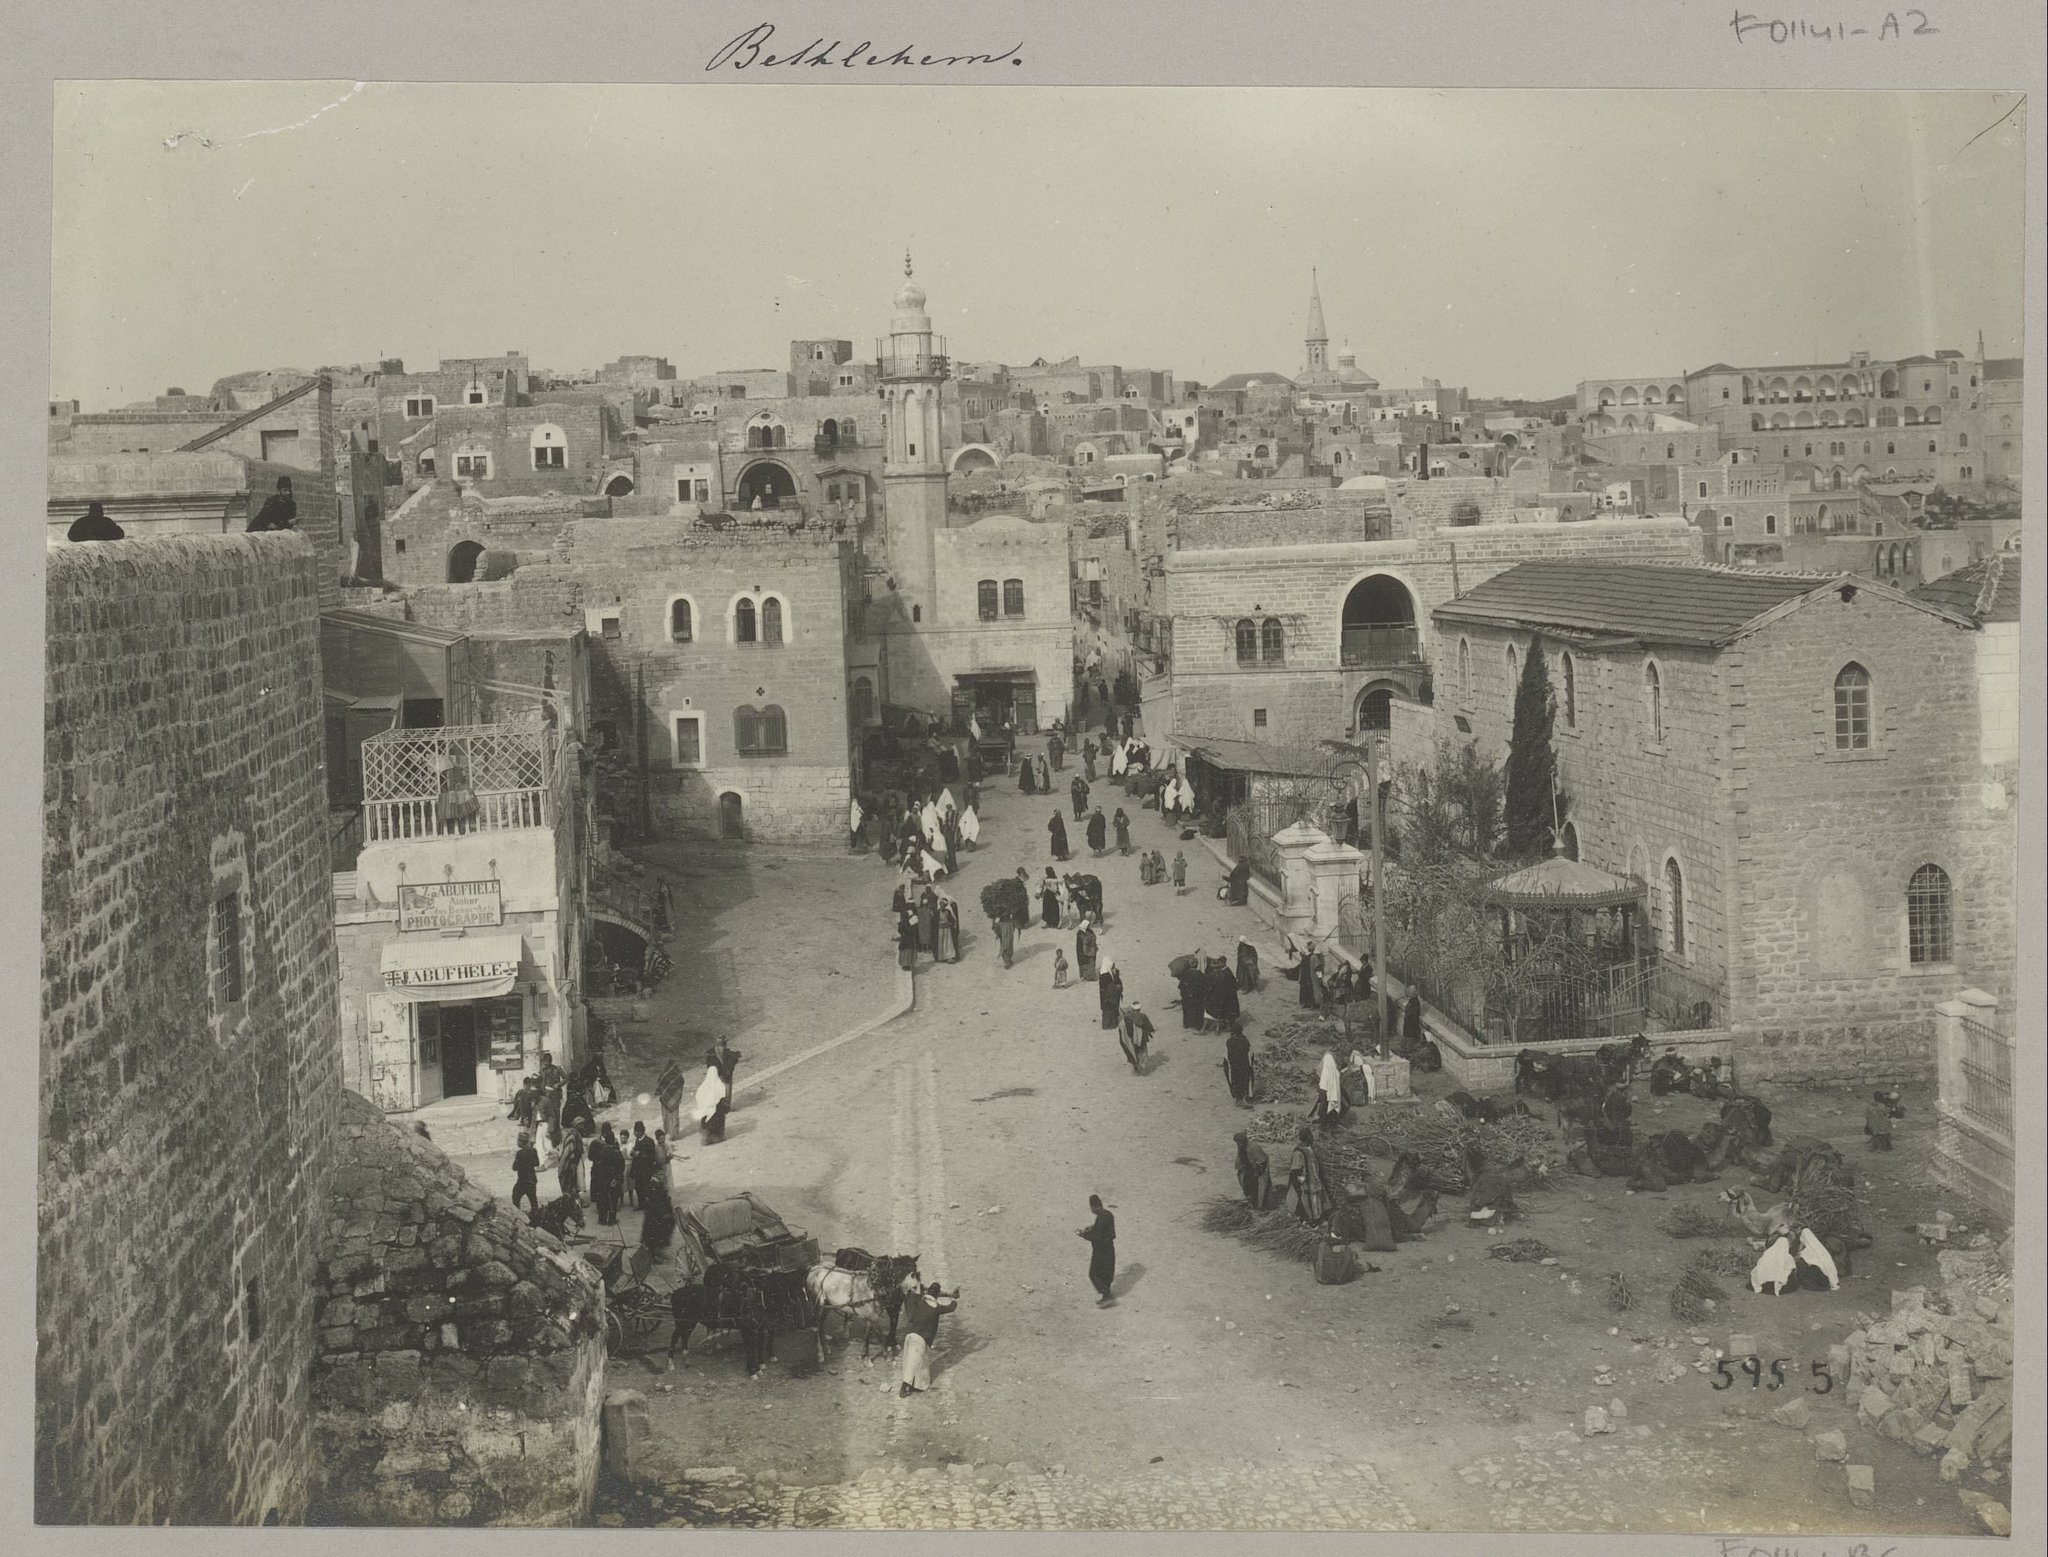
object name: photograph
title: Straatgezicht in Bethlehem met links fotostudio Abufhele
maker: Anonymous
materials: photographic support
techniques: gelatin silver print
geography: bethlehem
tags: studio ~ photographer, workshop, prospect of city, town panorama, silhouette of city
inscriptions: number: ‘595 5’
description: Onderdeel van Fotoalbum van een reis door Zuid-Europa en het Midden-Oosten.